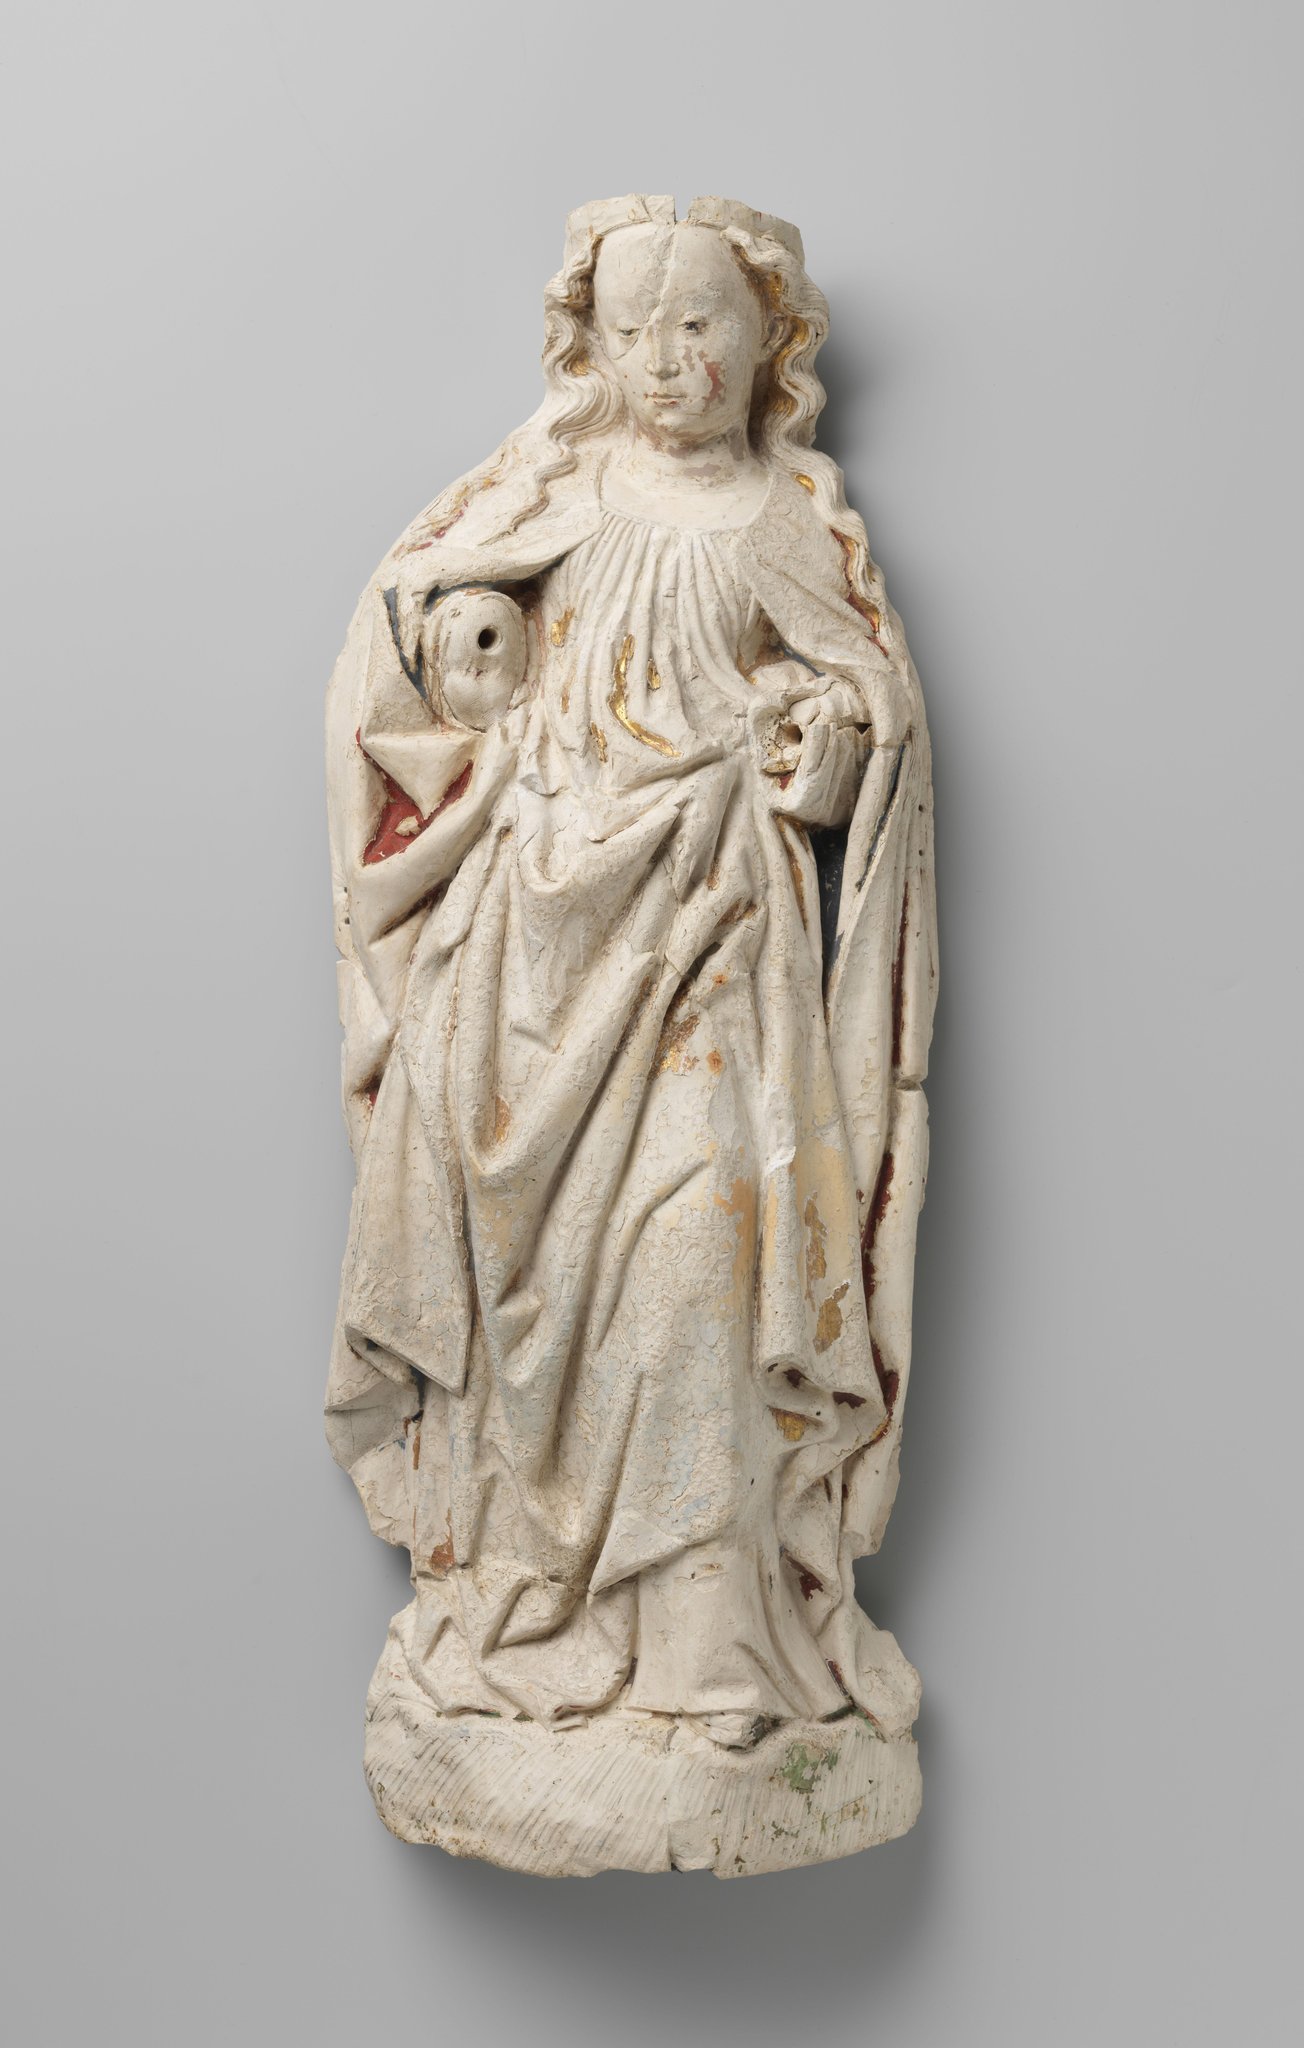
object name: sculpture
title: Female Saint (Virgin and Child?)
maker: Anonymous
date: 1470-1480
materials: clay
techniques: gilding, polychromy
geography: utrecht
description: The Virgin Mary (?). Pipeclay with remains of polychromy. Utrecht, c. 1480.